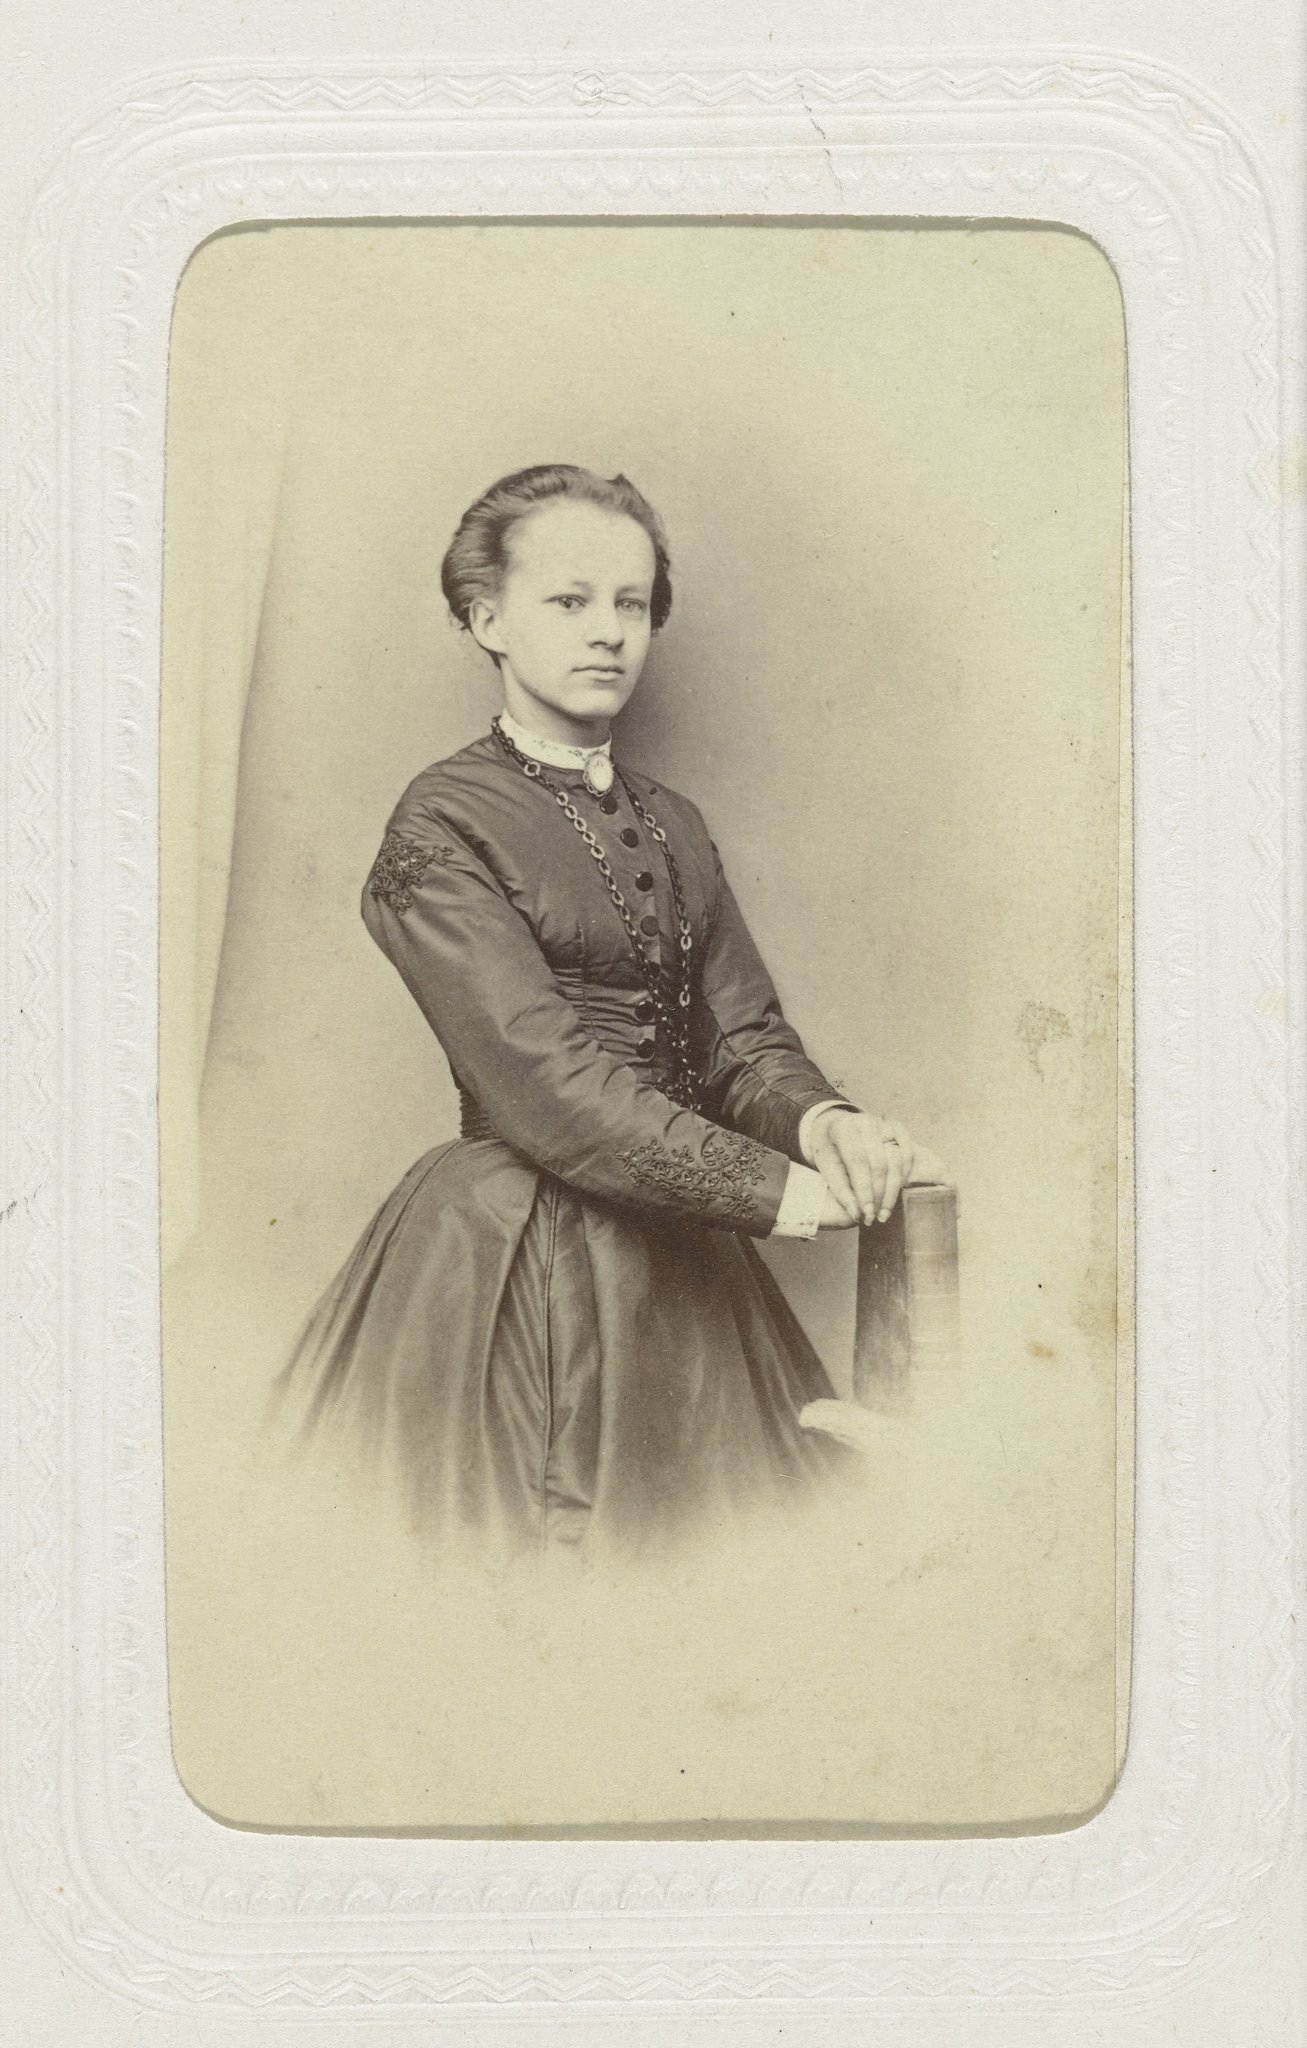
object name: carte de visite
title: Studioportret van een jonge vrouw in een hoog gesloten zwarte jurk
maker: leonard de koningh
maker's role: draughtsman, painter, print maker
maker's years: 1810-1887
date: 1863-1866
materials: cardboard, paper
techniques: albumen print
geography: dordrecht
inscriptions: name: ‘L. de Koningh Dordrecht’